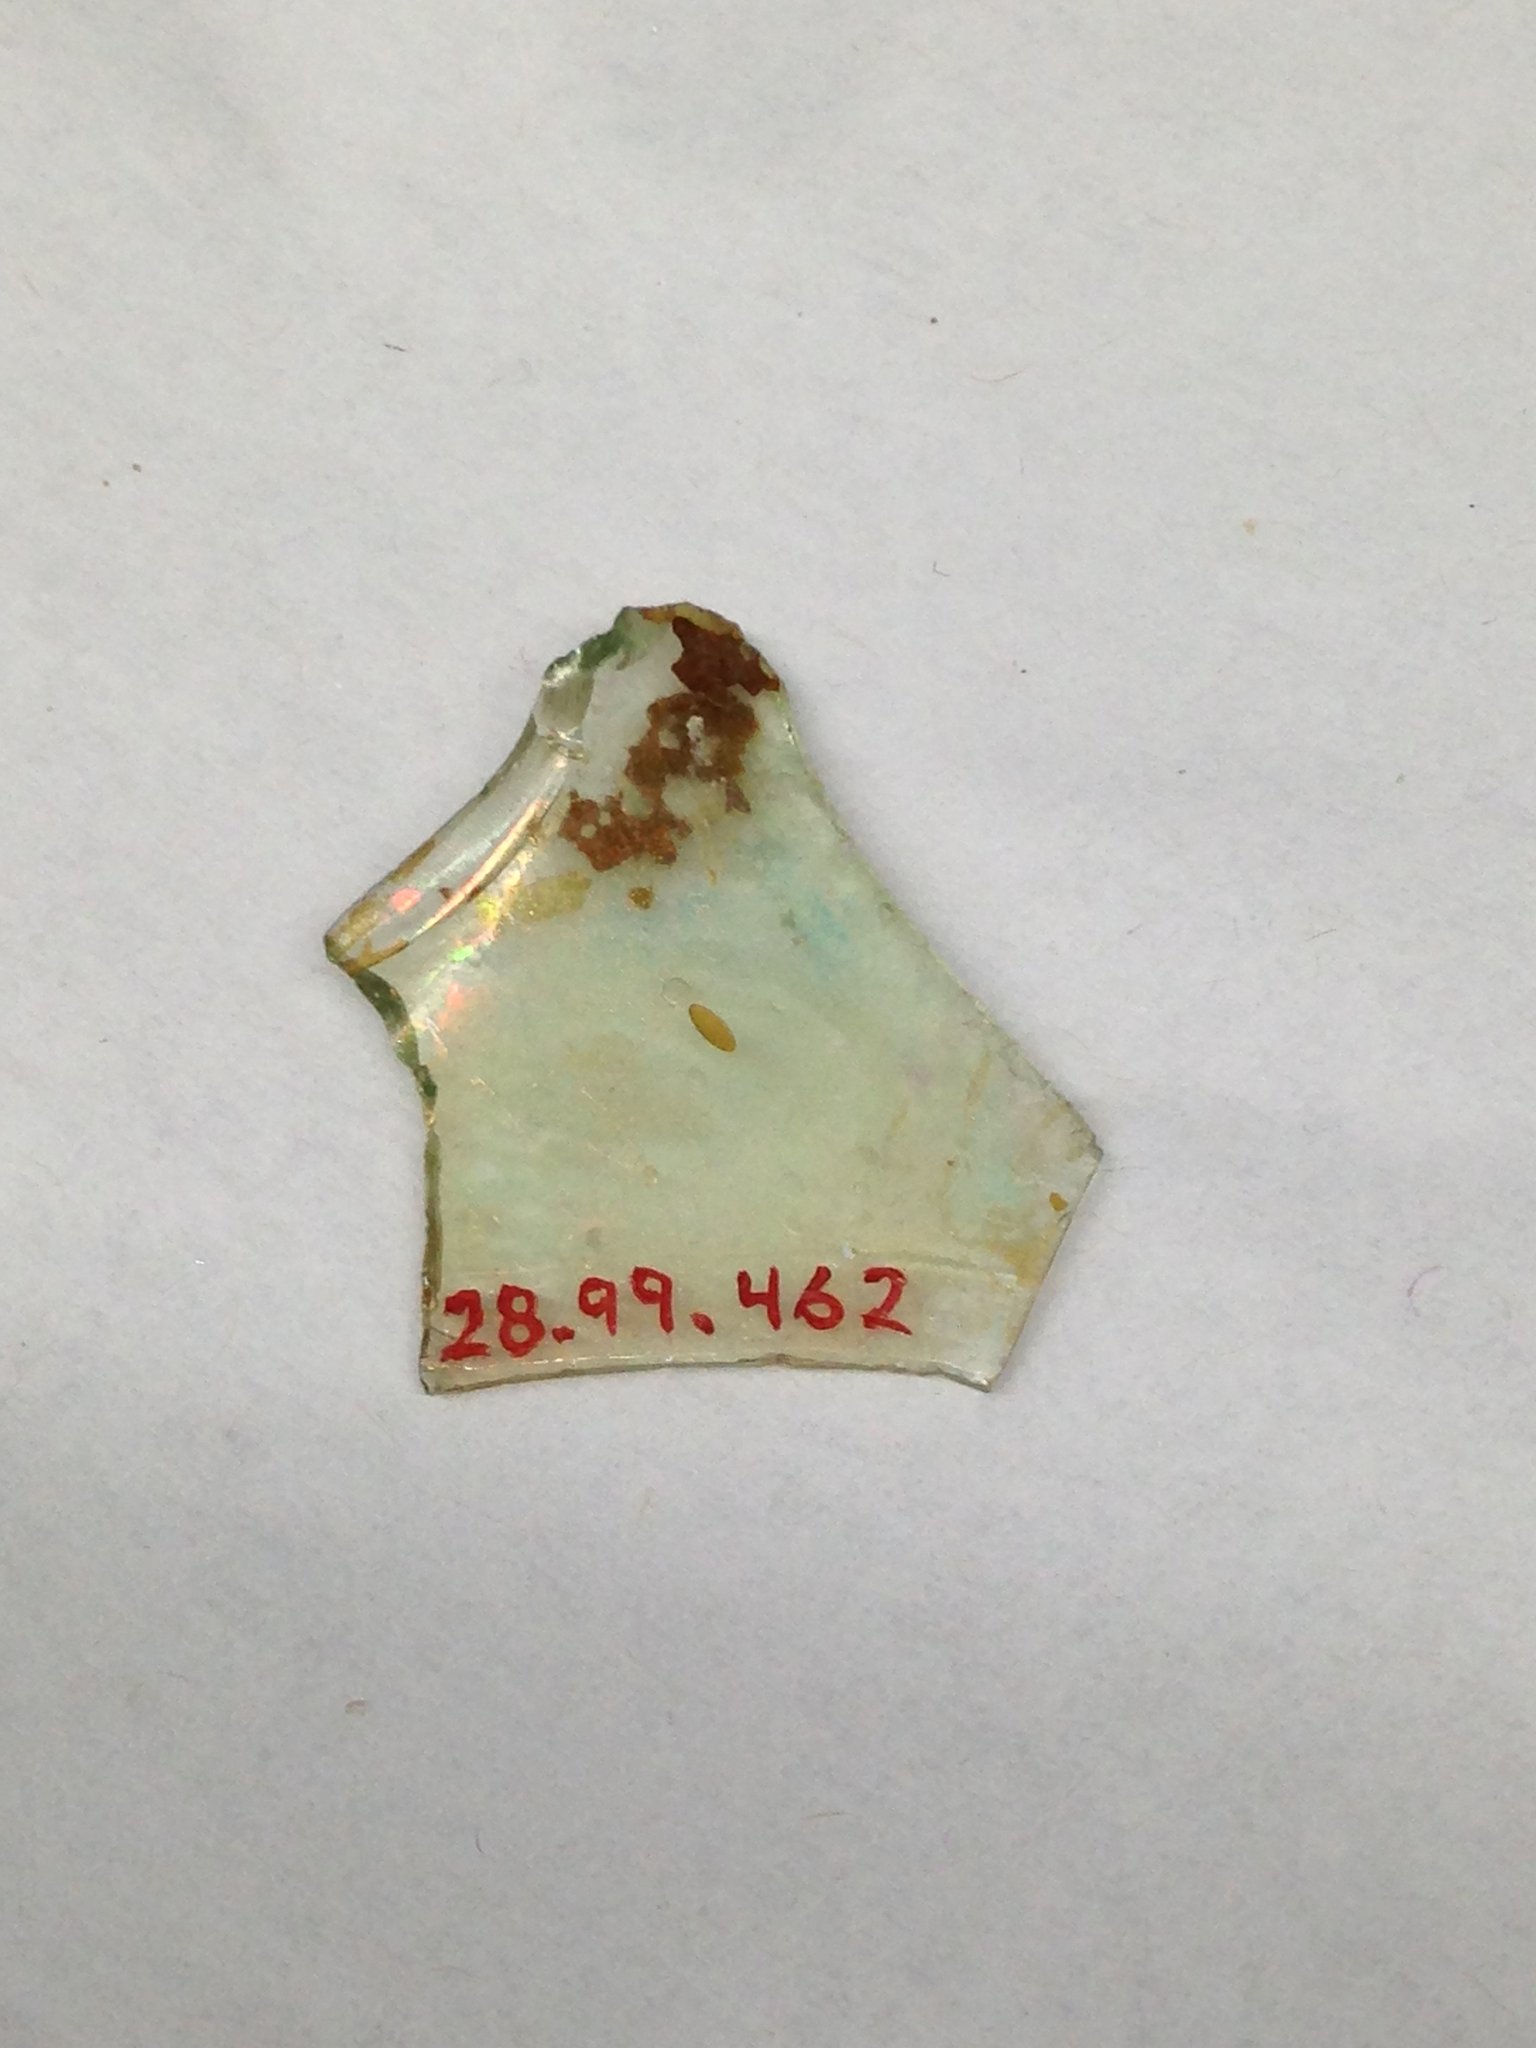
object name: fragment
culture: european or middle eastern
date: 1150-1250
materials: ceramic, glass